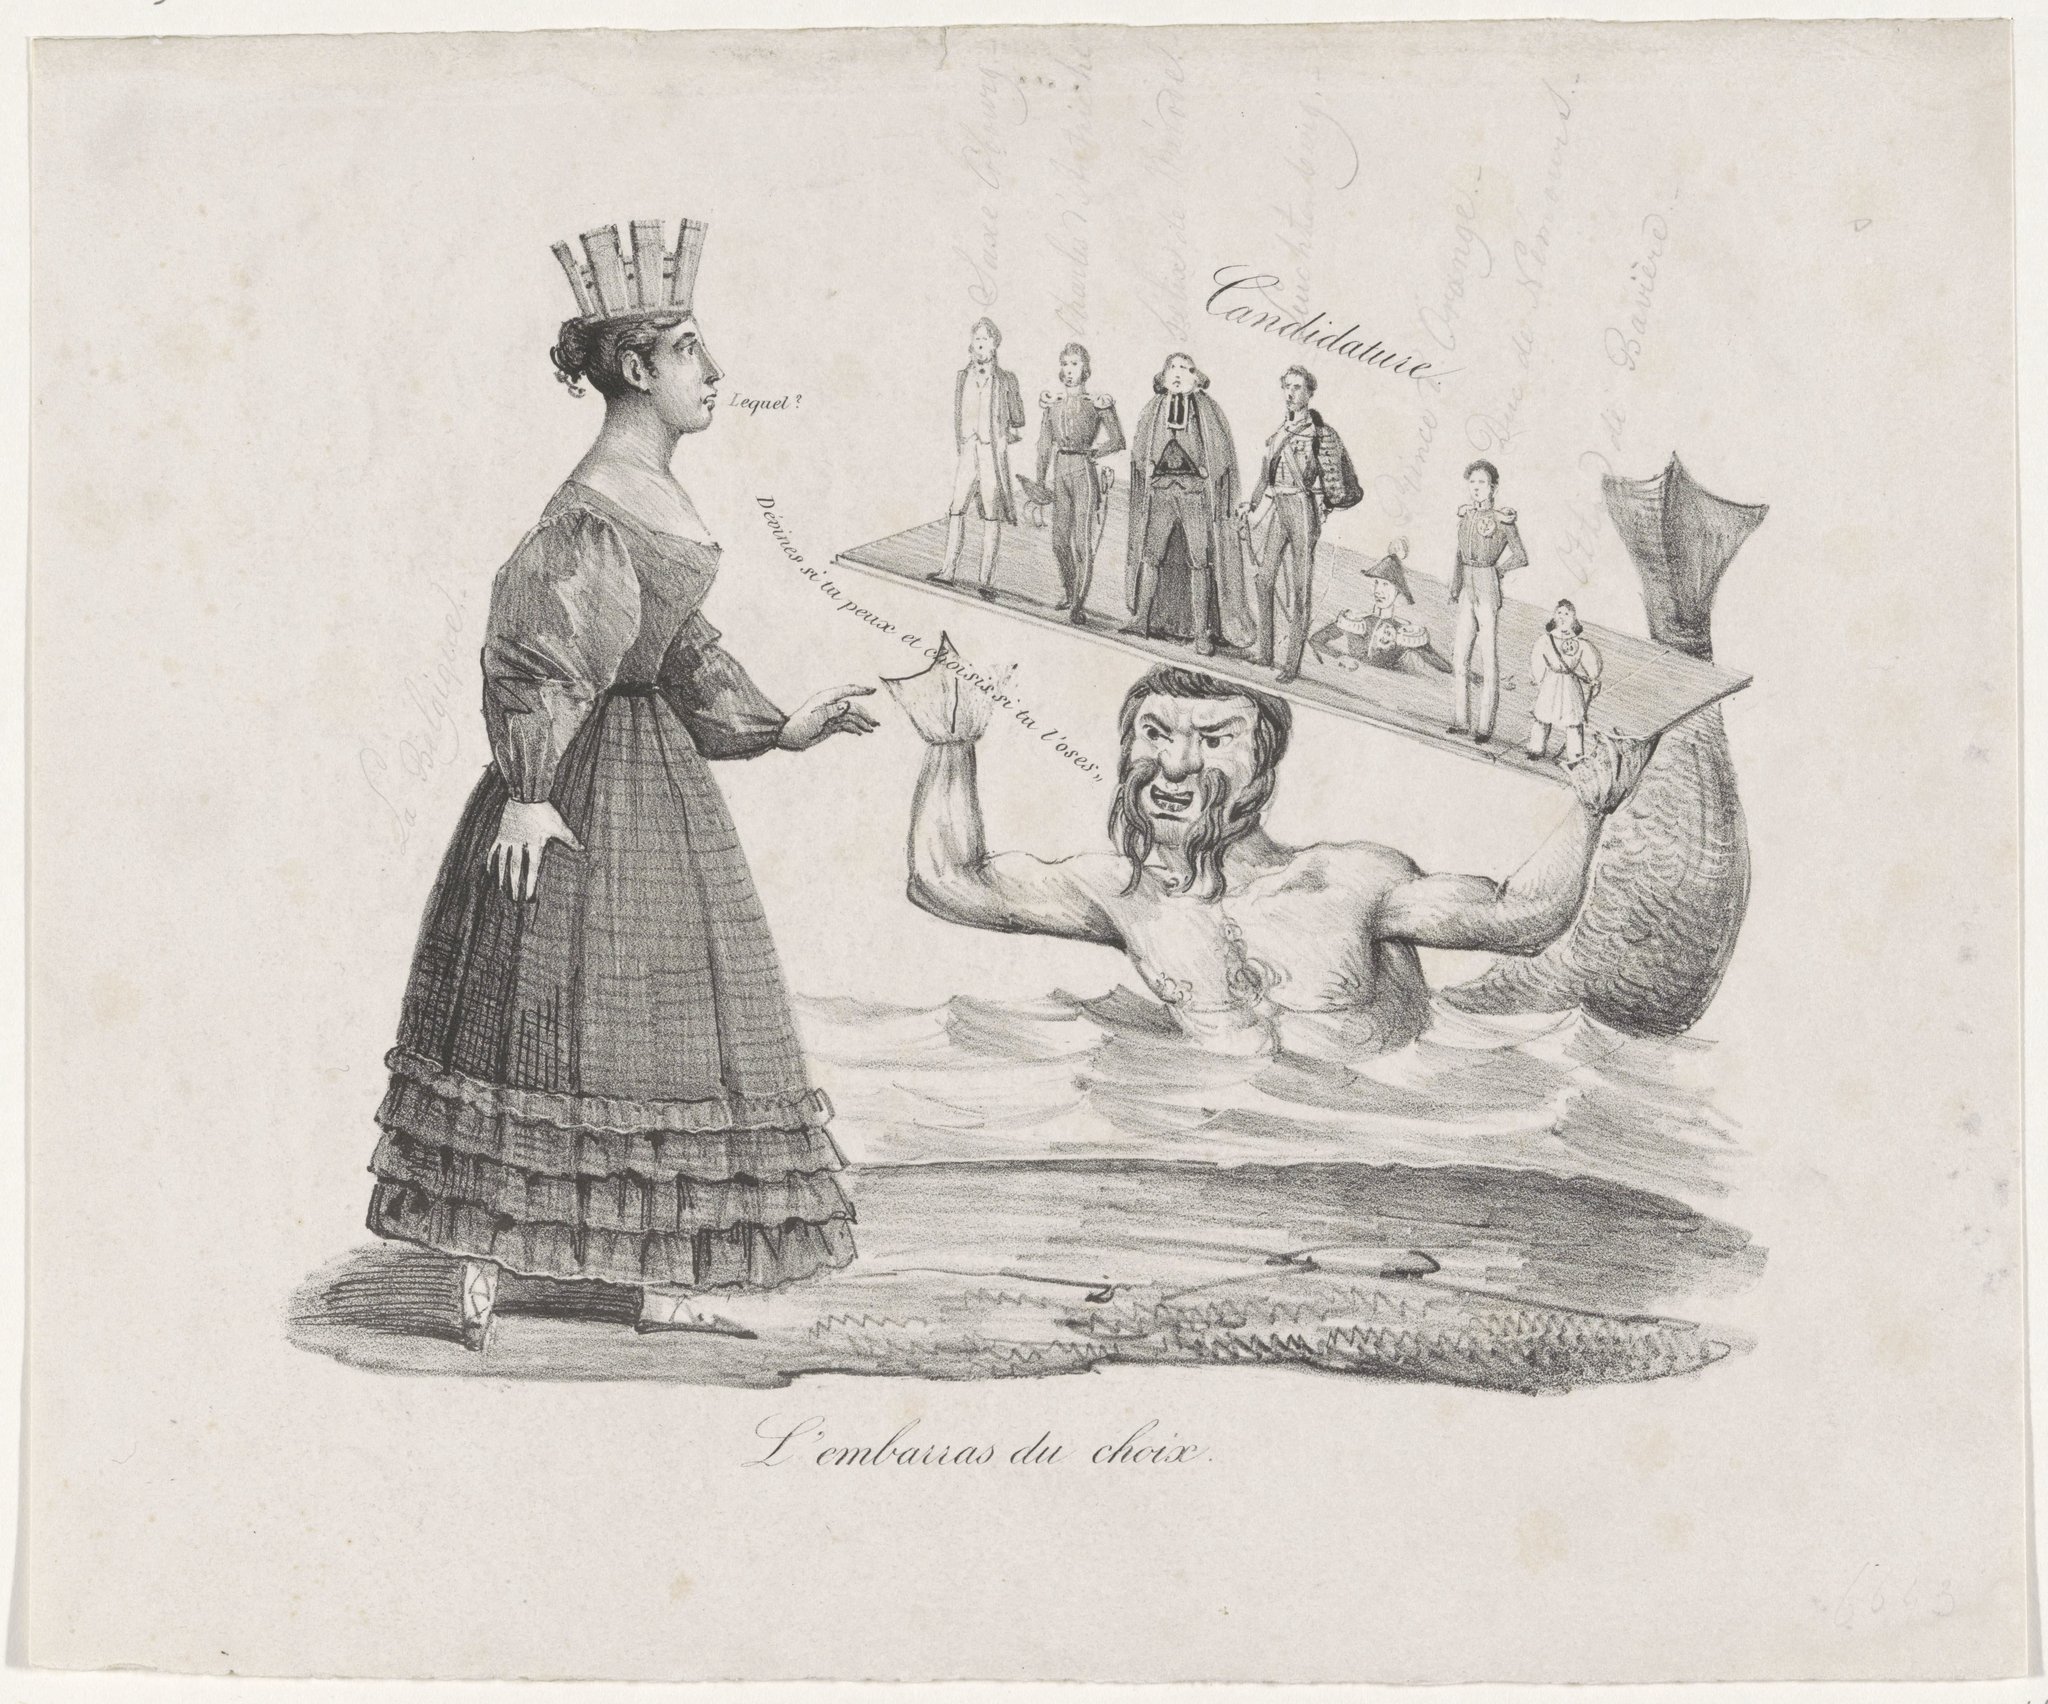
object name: cartoon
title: Een moeilijke keuze, 1831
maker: Anonymous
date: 1831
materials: paper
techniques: lithograph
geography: netherlands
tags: personifications of countries, nations, states, districts, etc., king, belgium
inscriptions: collector's mark: Lugt 2166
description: Spotprent op de koningskeuze in België, februari 1831. De Belgische Maagd in verlegenheid bij het kiezen tussen de kandidaten voor de Belgische kroon. Een zeemeerman houdt een plank omhoog waarop de zeven kandiaten staan.